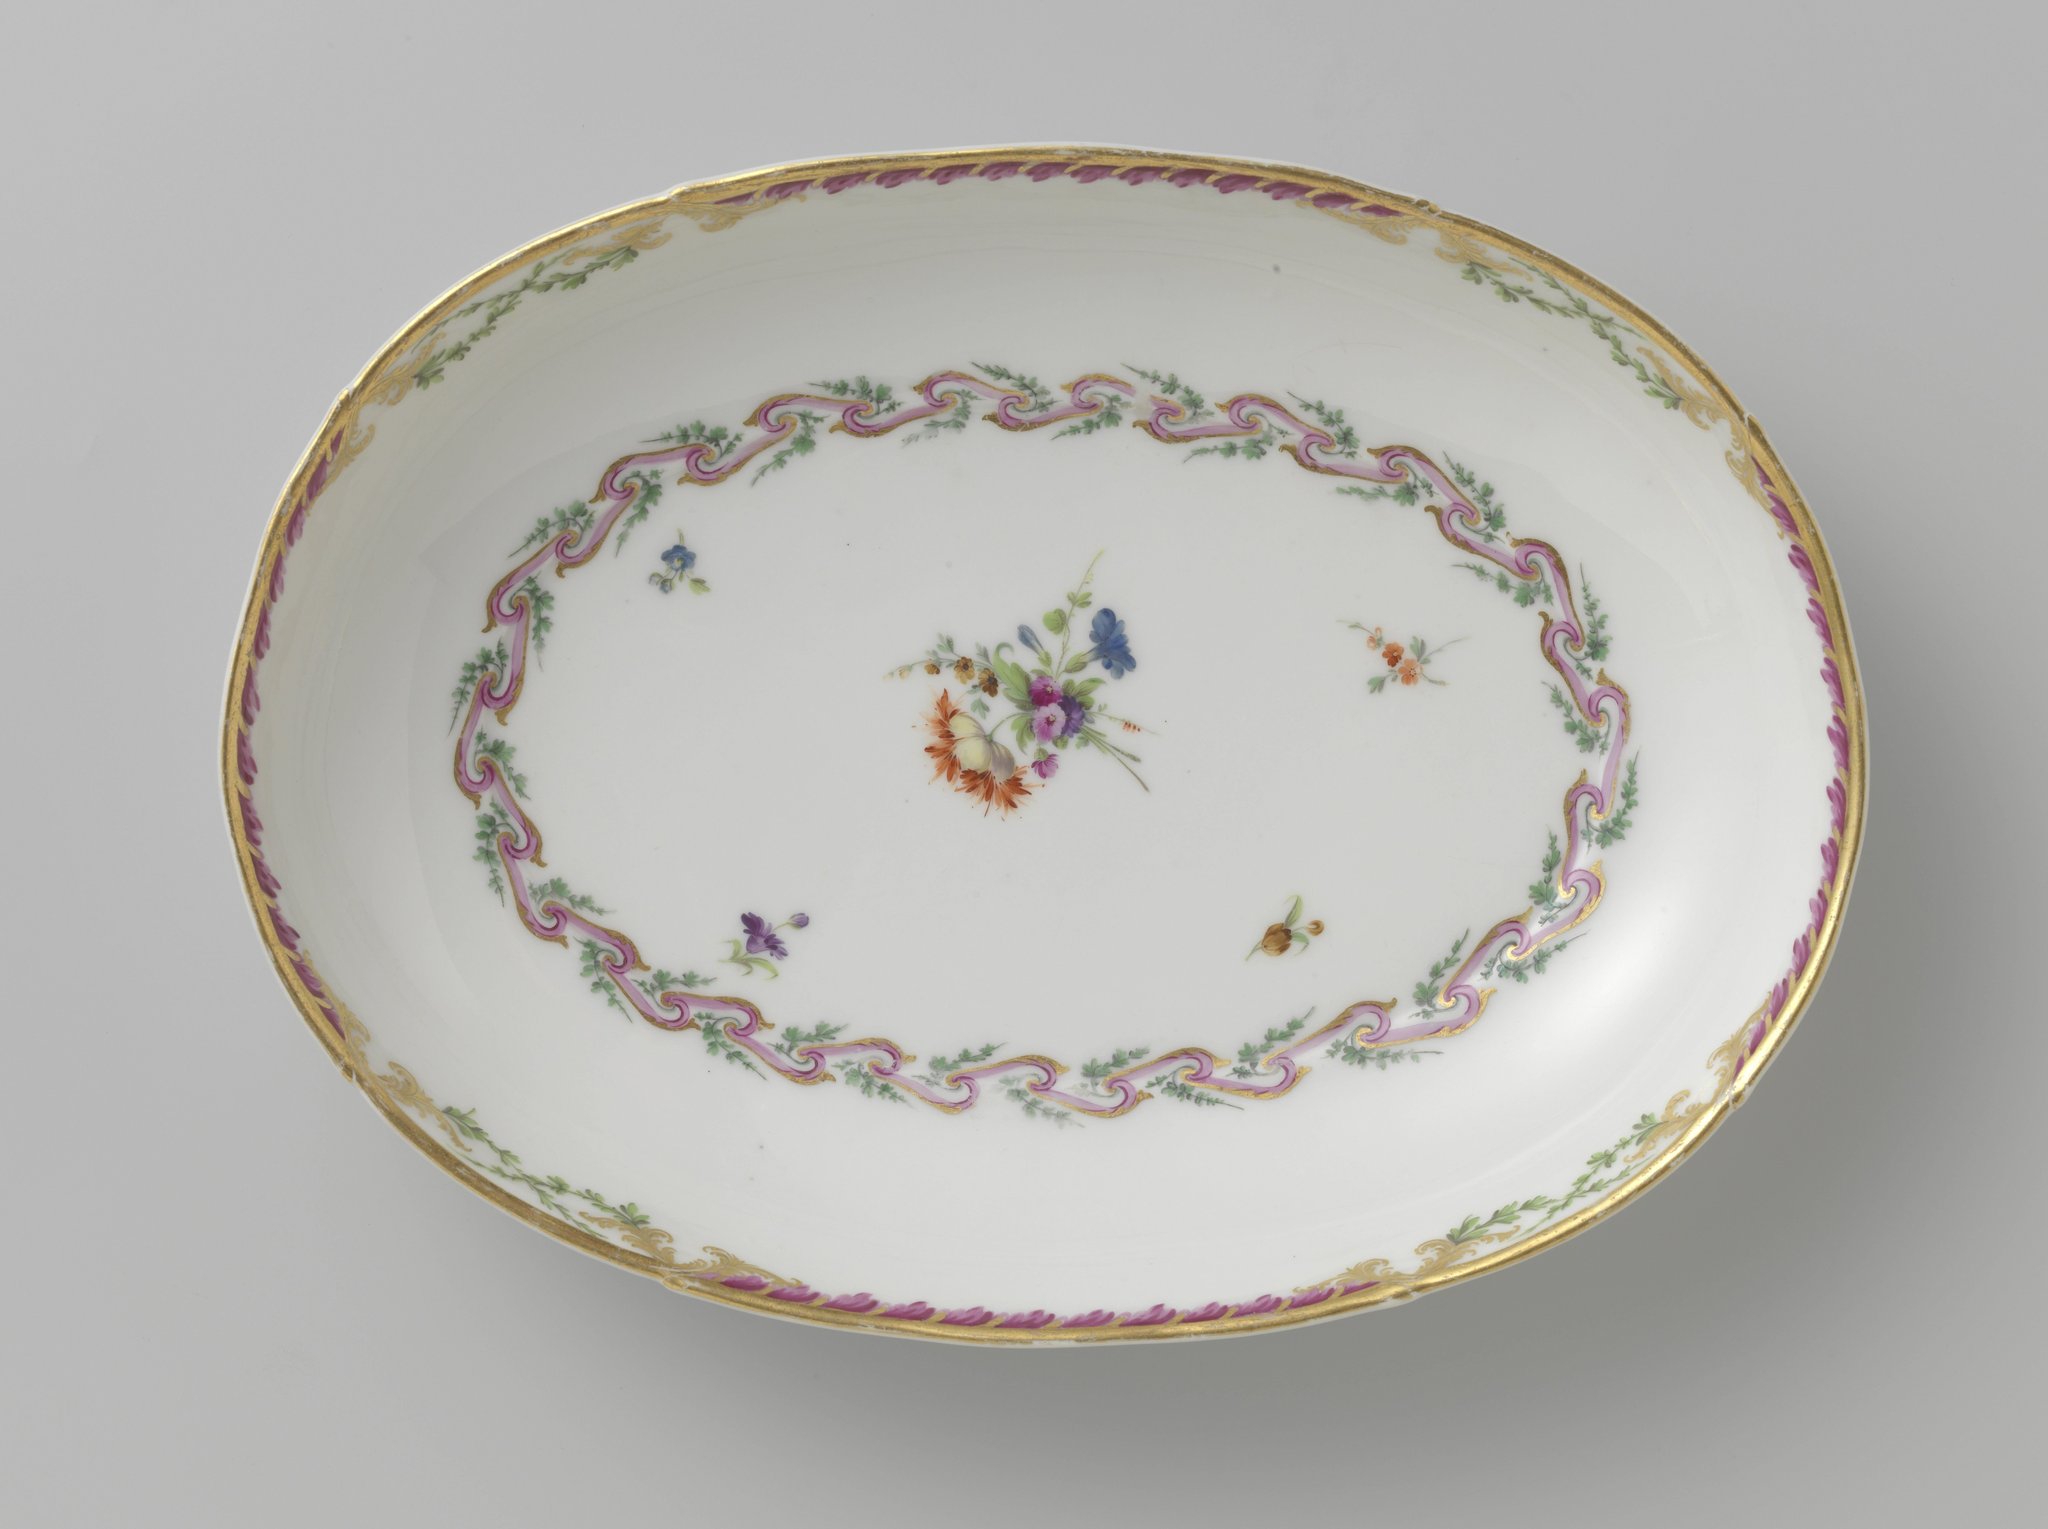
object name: dish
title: Schaal, diep en ovaal van vorm,behorend bij een servies met geslingerd lintmotief met bladertakken, bloemboeketten en gestrooide bloemtakken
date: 1780-1820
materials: porcelain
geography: amsterdam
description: Schaal, diep en ovaal van vorm, behorend bij een servies van porselein, versierd met een geslingerd lintmotief in paars en goud met groene bladertakken, bloemboeketten en gestrooide bloemtakken. Randen lichtgegolfd met decoratie in goud met paars bladmotief waartussen groen gekruist bladmotief. Gemerkt: M.O.L. en Amstel.